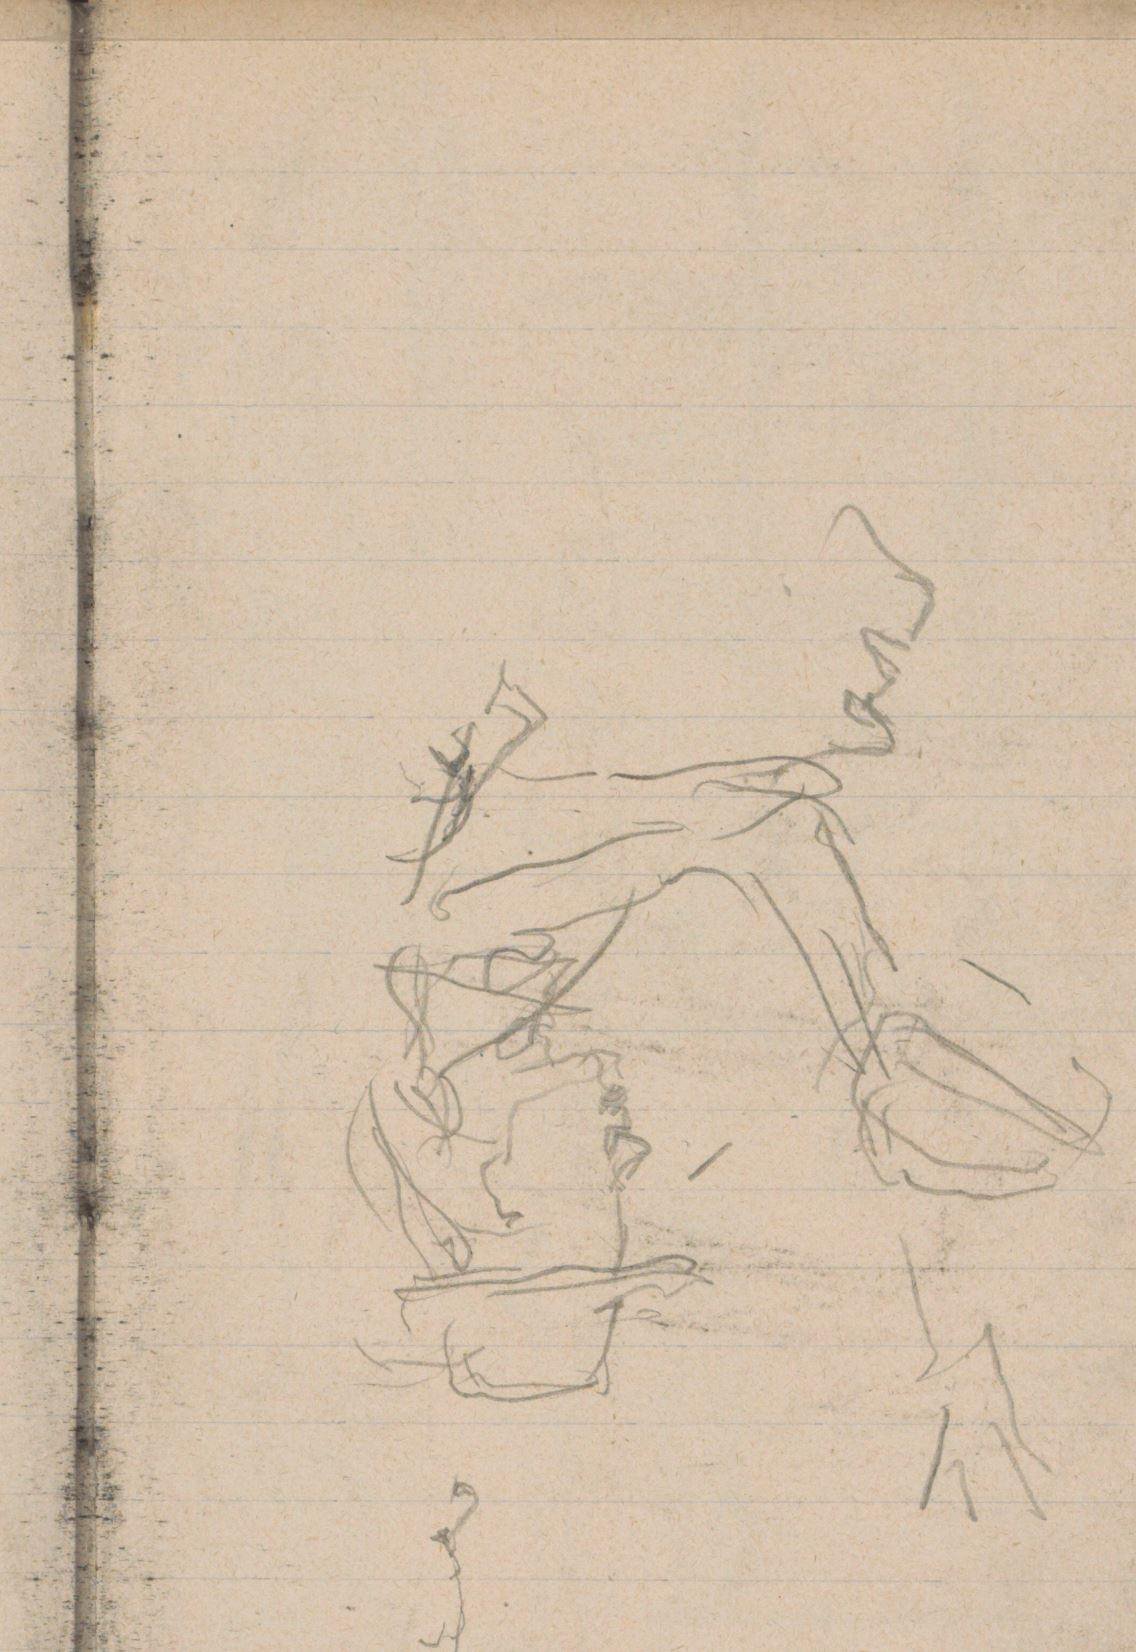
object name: sketchbook leaf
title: Figuurstudies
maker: george hendrik breitner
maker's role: draughtsman, painter, print maker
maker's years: 1857-1923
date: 1903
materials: pencil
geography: amsterdam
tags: adult woman, adult man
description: Pagina 14 uit een schetsboek met 32 bladen.